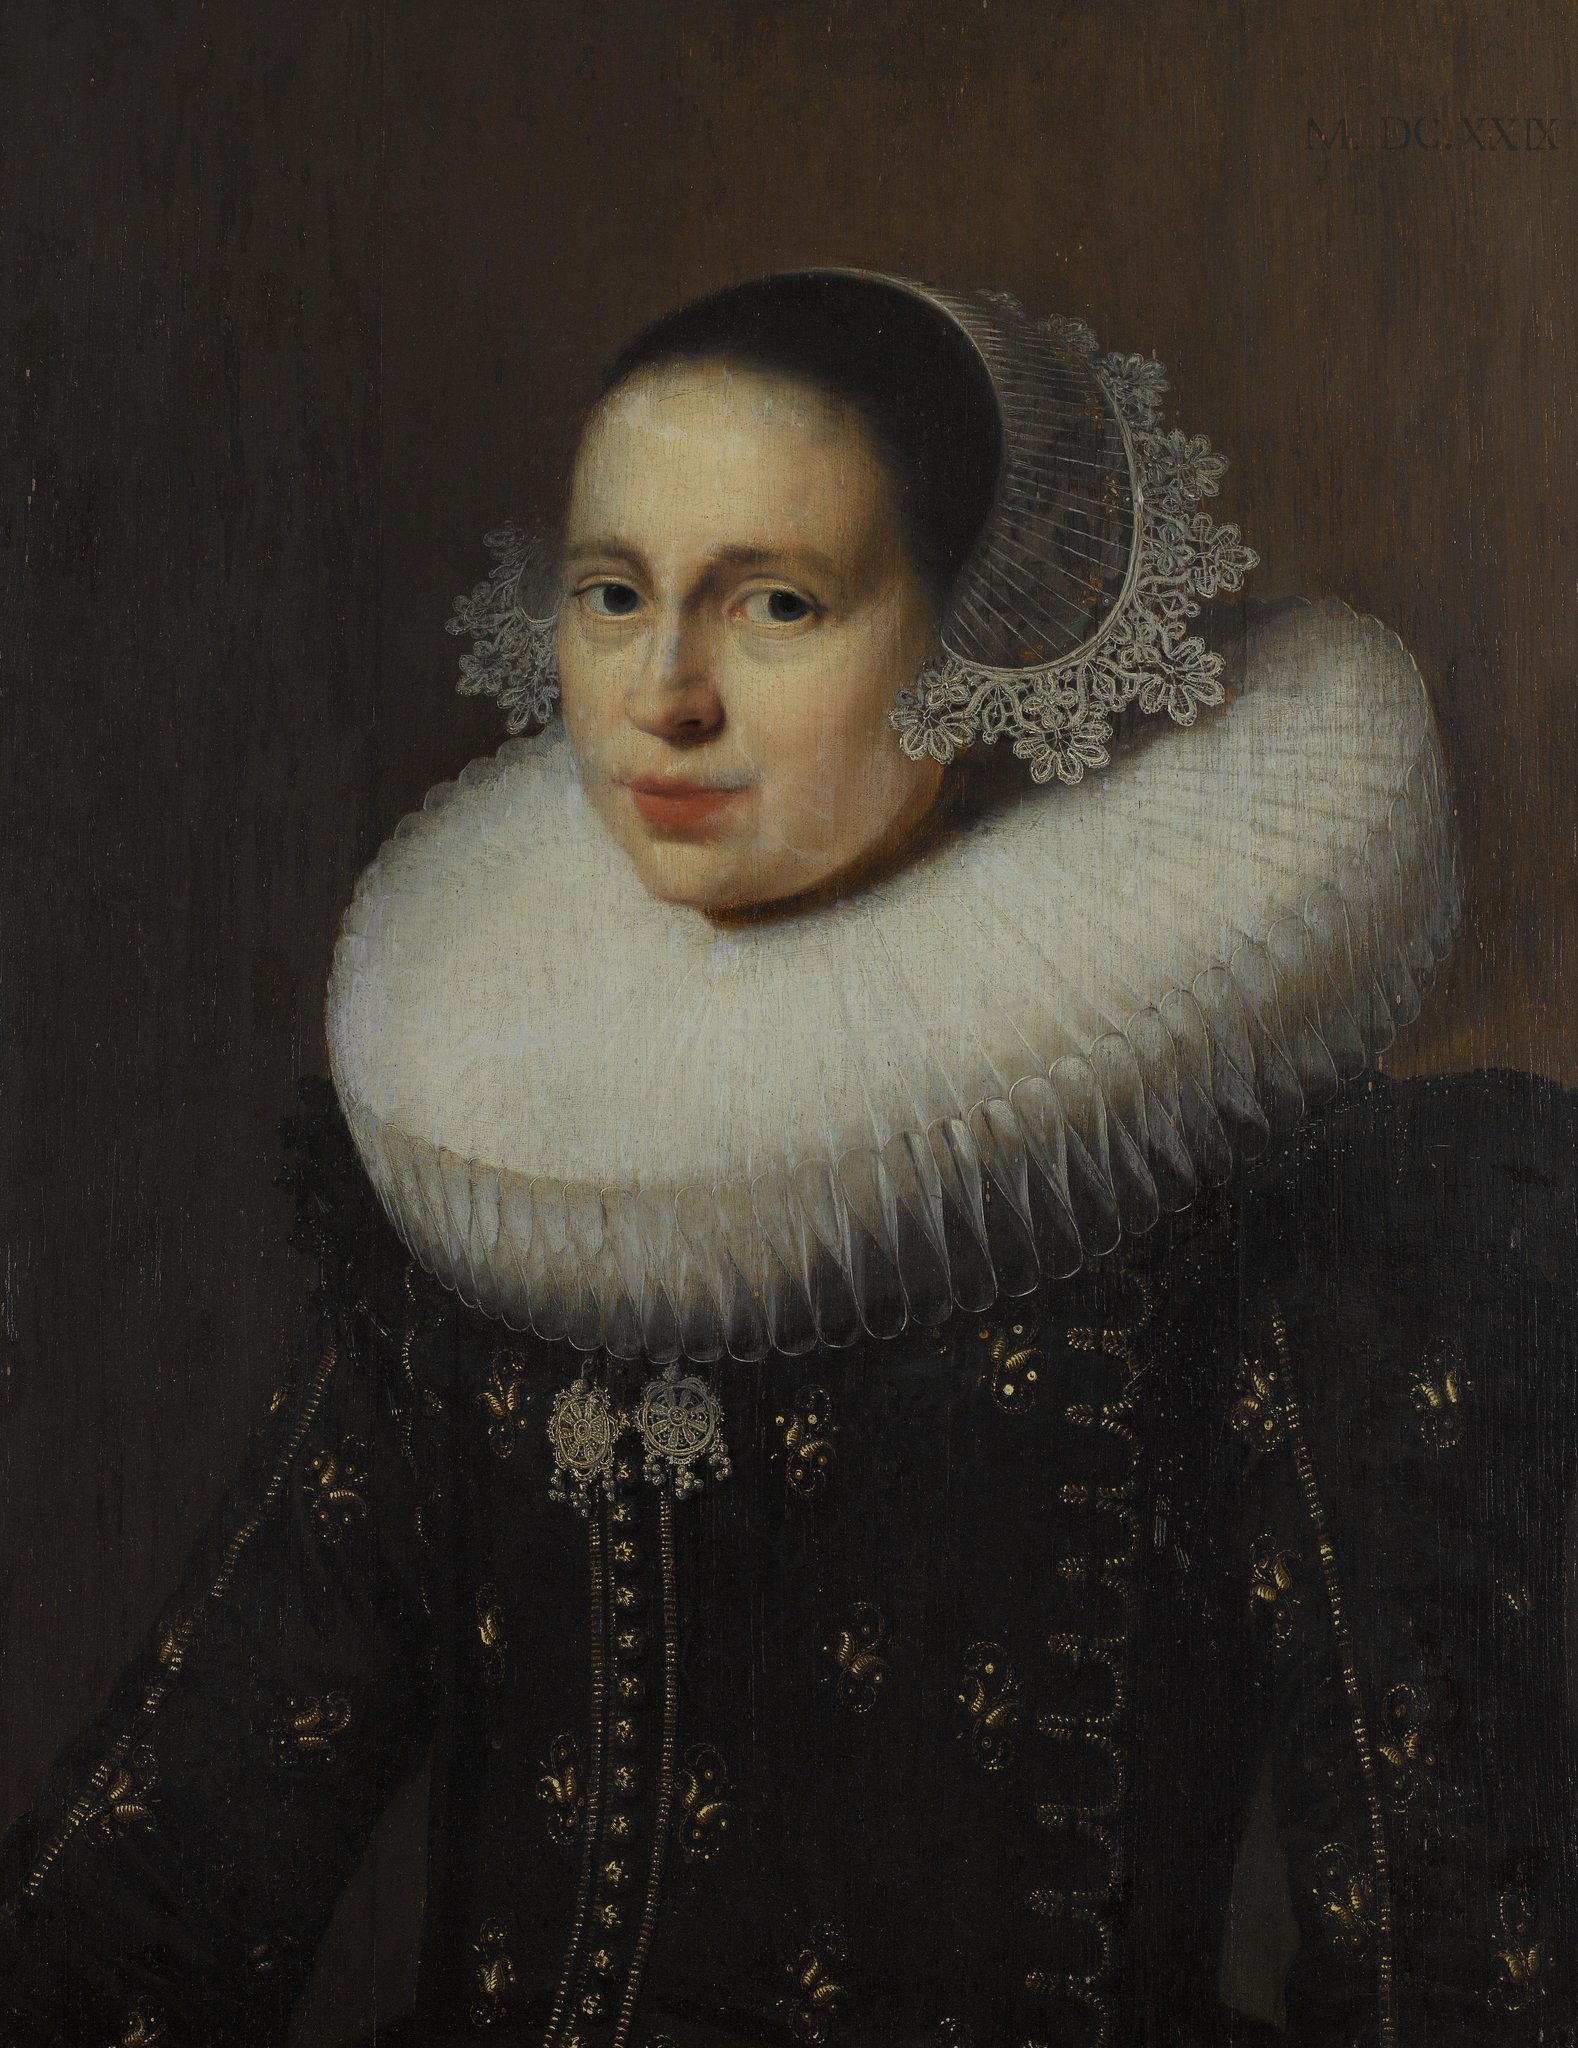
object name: painting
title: Portrait of Hendrickje Uylenburgh (1600-ca. 1682). Wife of the Artist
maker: wybrand de geest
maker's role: draughtsman, painter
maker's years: 1592-1665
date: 1629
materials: oil, panel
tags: historical persons - bb - woman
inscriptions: date, top right, in dark green: ‘M.DC.XXIX’, inscription, on the reverse, in white paint: ‘HENRIKIEN ULENBVRGH / GEBOREN INT’ IAER / 1600. / DEN 3 VAN MEERT.’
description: Portret van Hendrickje Uylenburgh, de echtgenote van de schilder Wybrand de Geest. Buste naar links, met een grote kanten kraag en een kleine kanten mutsje. Pendant van SK-A-1780.